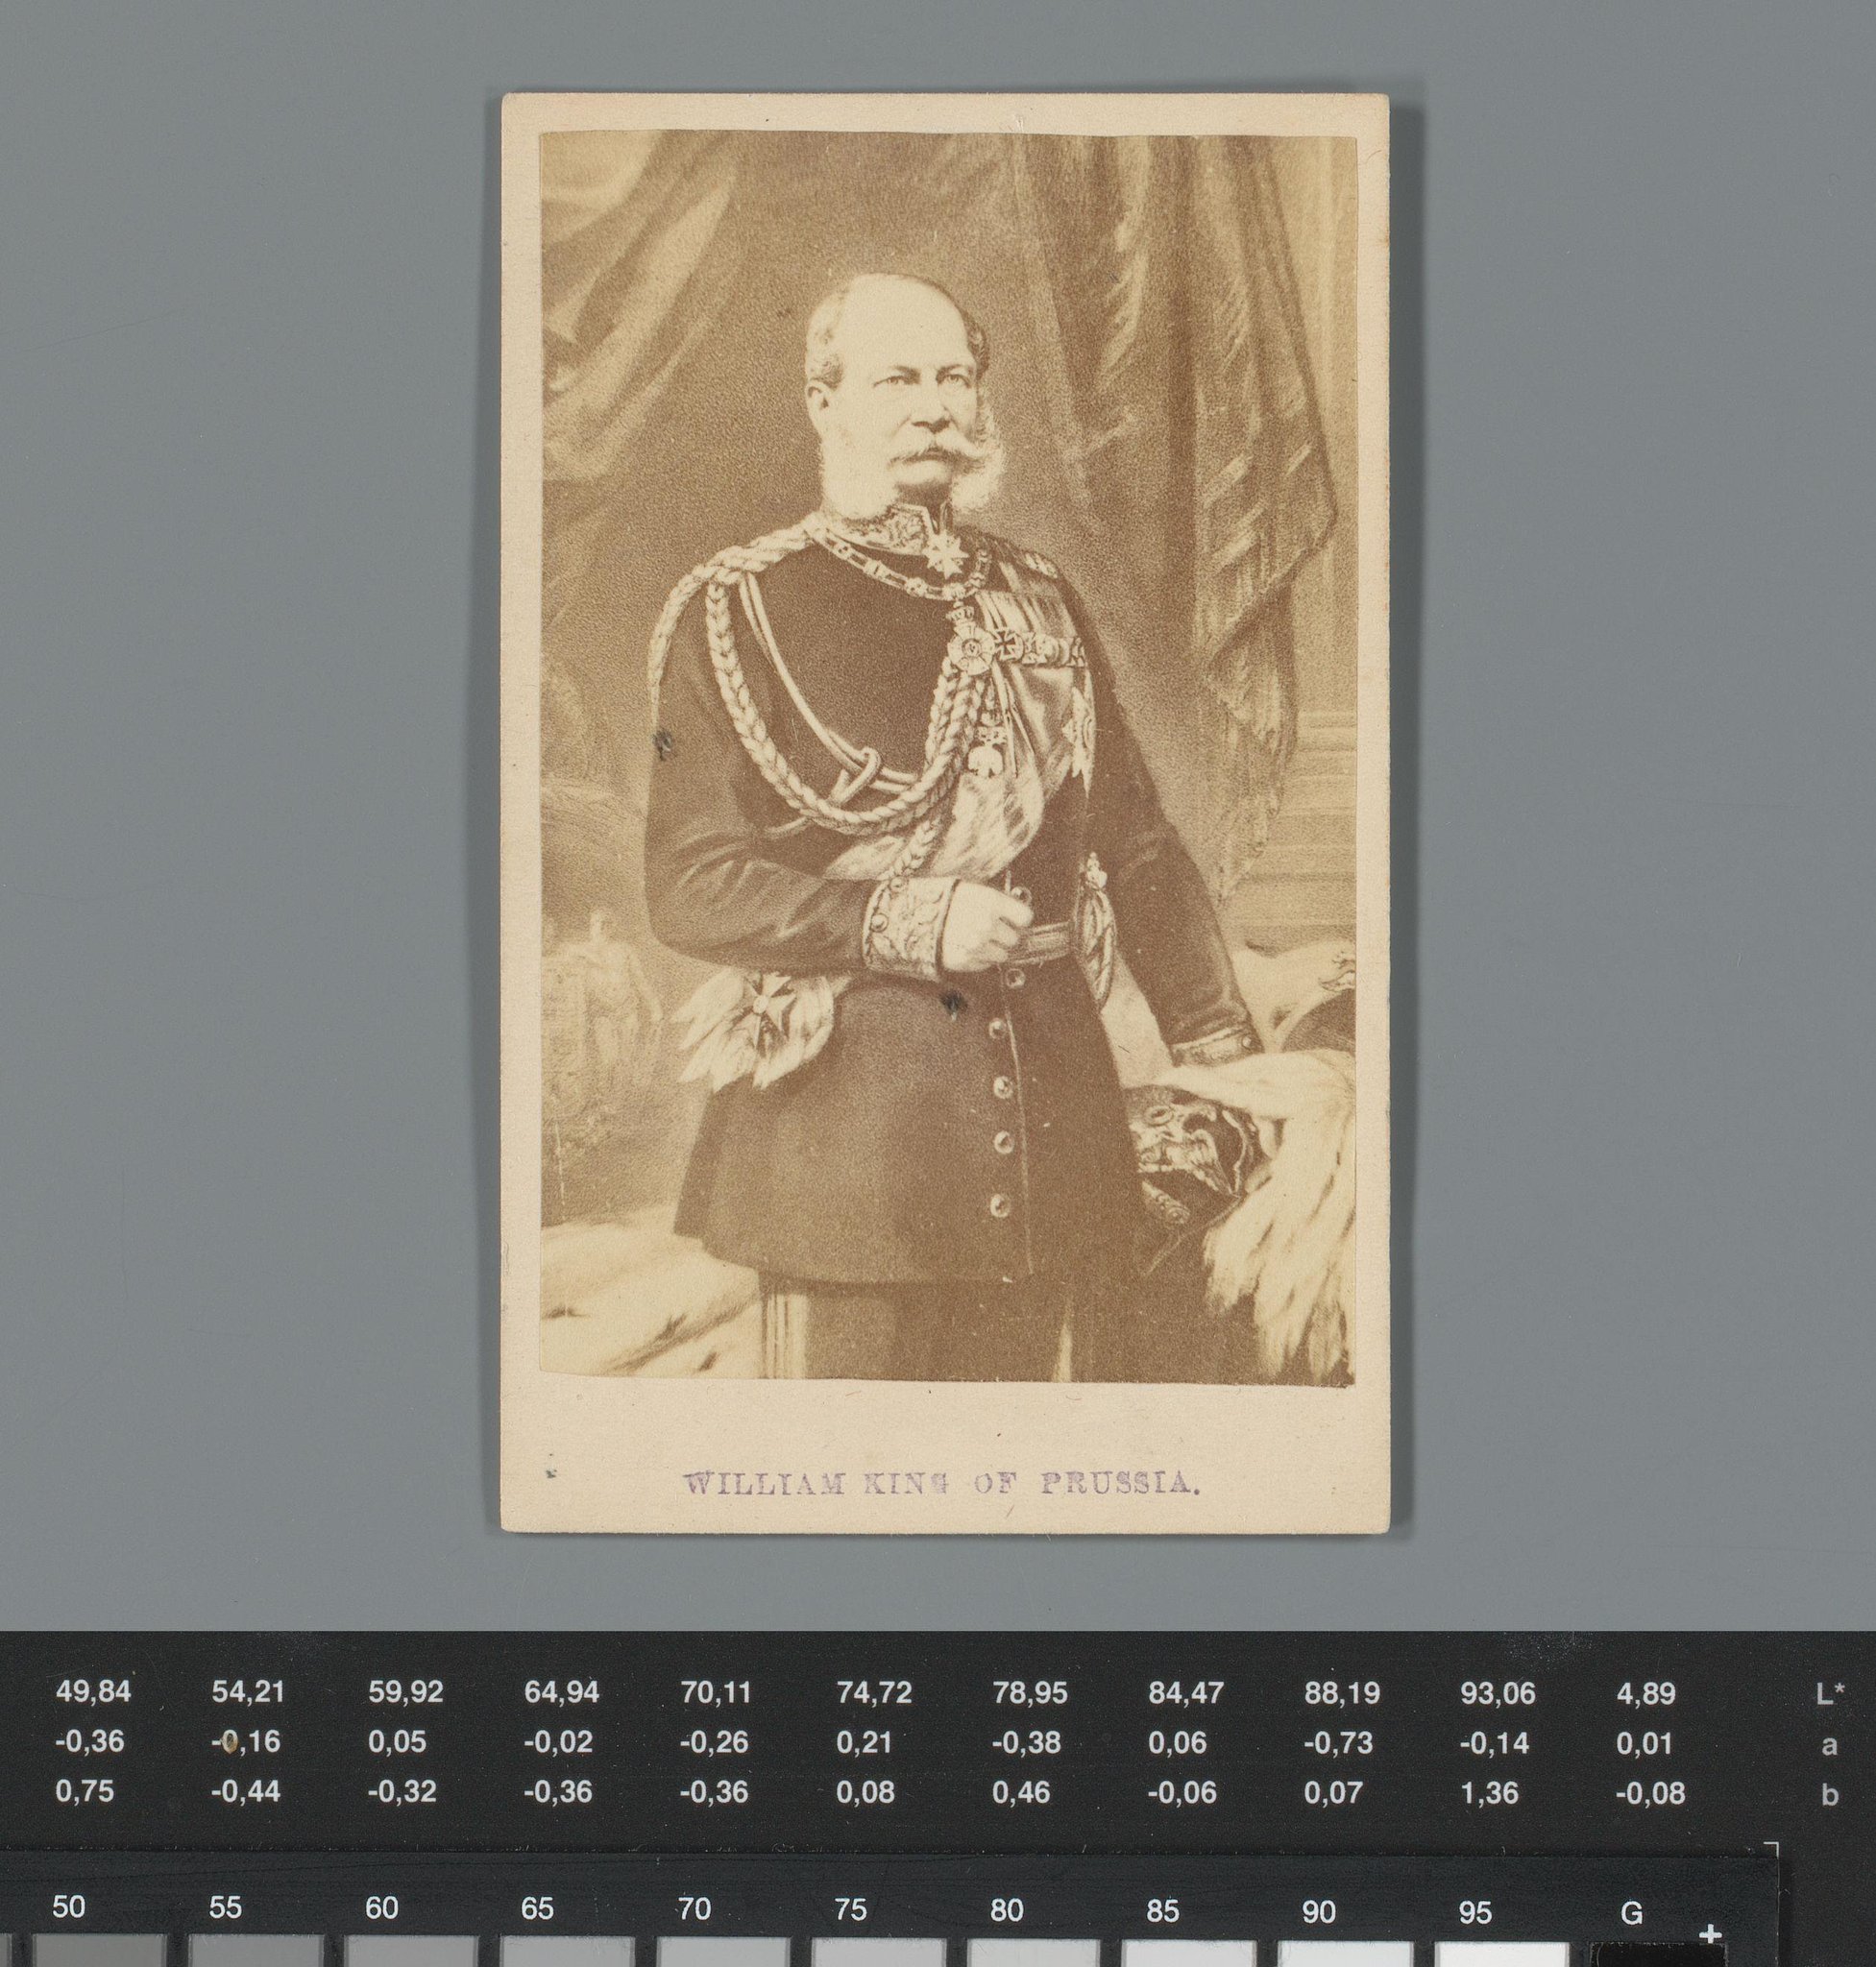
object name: photograph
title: Portret van Wilhelm I van Duitsland met reclame voor Abbot's Cheap store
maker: Anonymous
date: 1850-1915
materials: cardboard, photographic support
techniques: albumen print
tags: berlin, wilhelm i (keizer van duitsland), advertising, historical persons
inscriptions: inscription: ‘(...)’